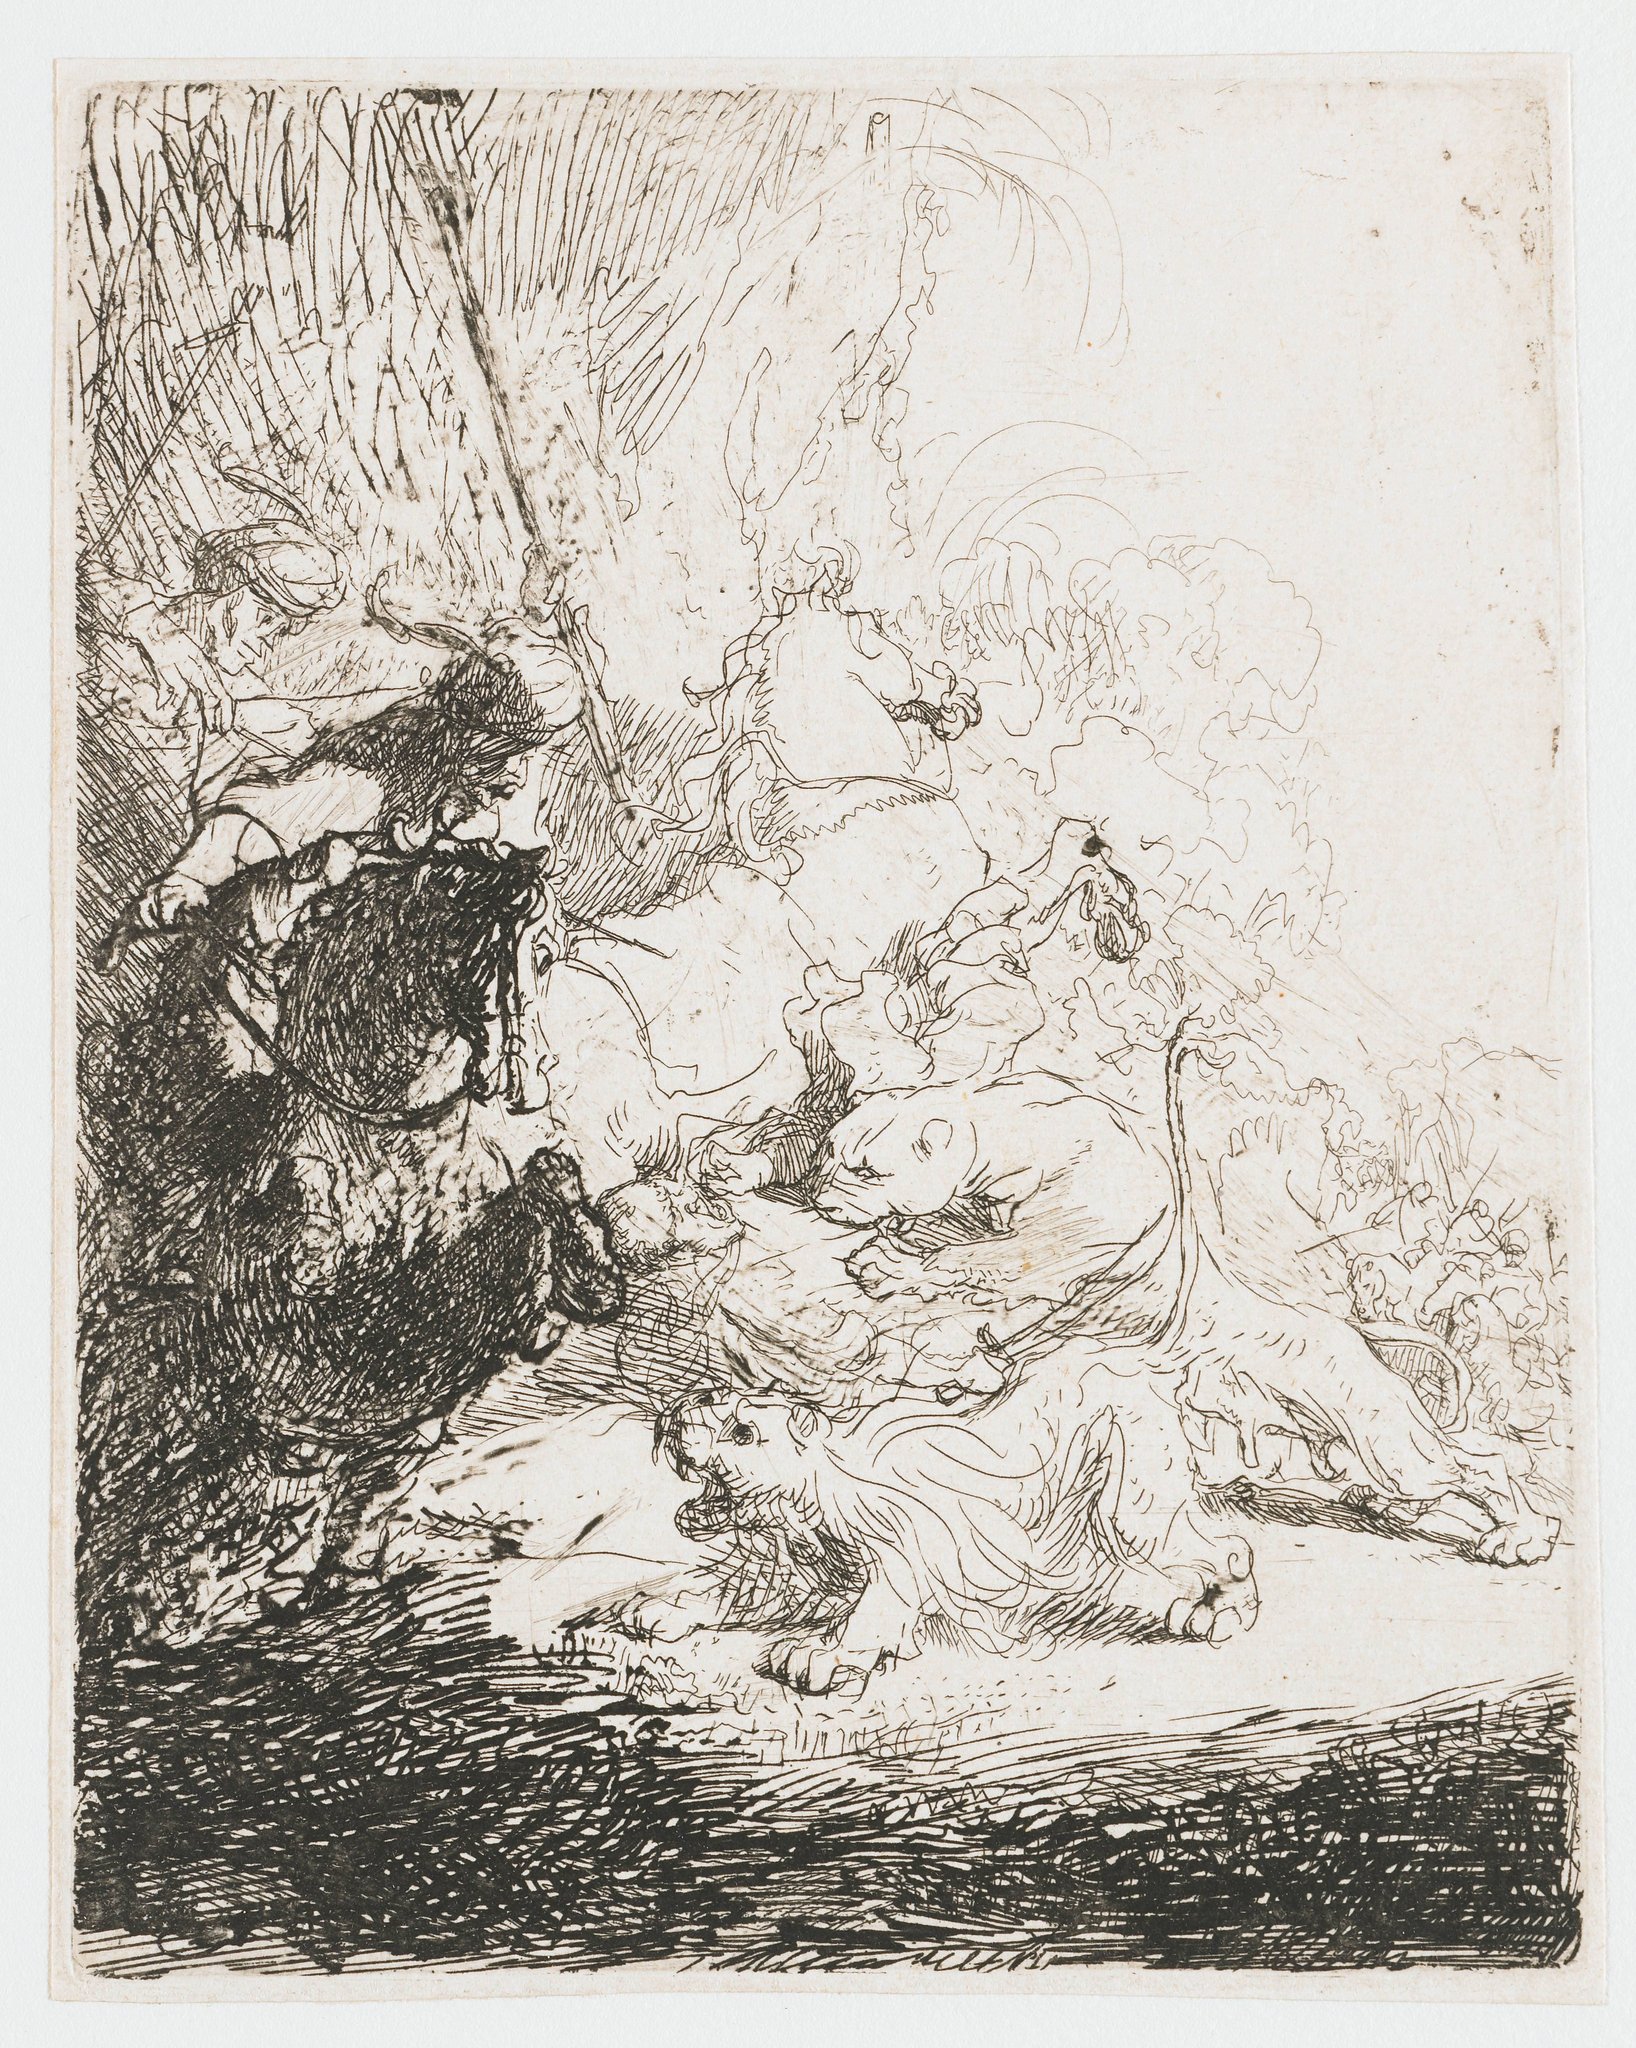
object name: print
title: The small lion hunt (with two lions)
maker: rembrandt van rijn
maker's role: draughtsman, painter, print maker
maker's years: 1606-1669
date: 1629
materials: paper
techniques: etching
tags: lion hunt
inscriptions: collector's mark: Lugt 240